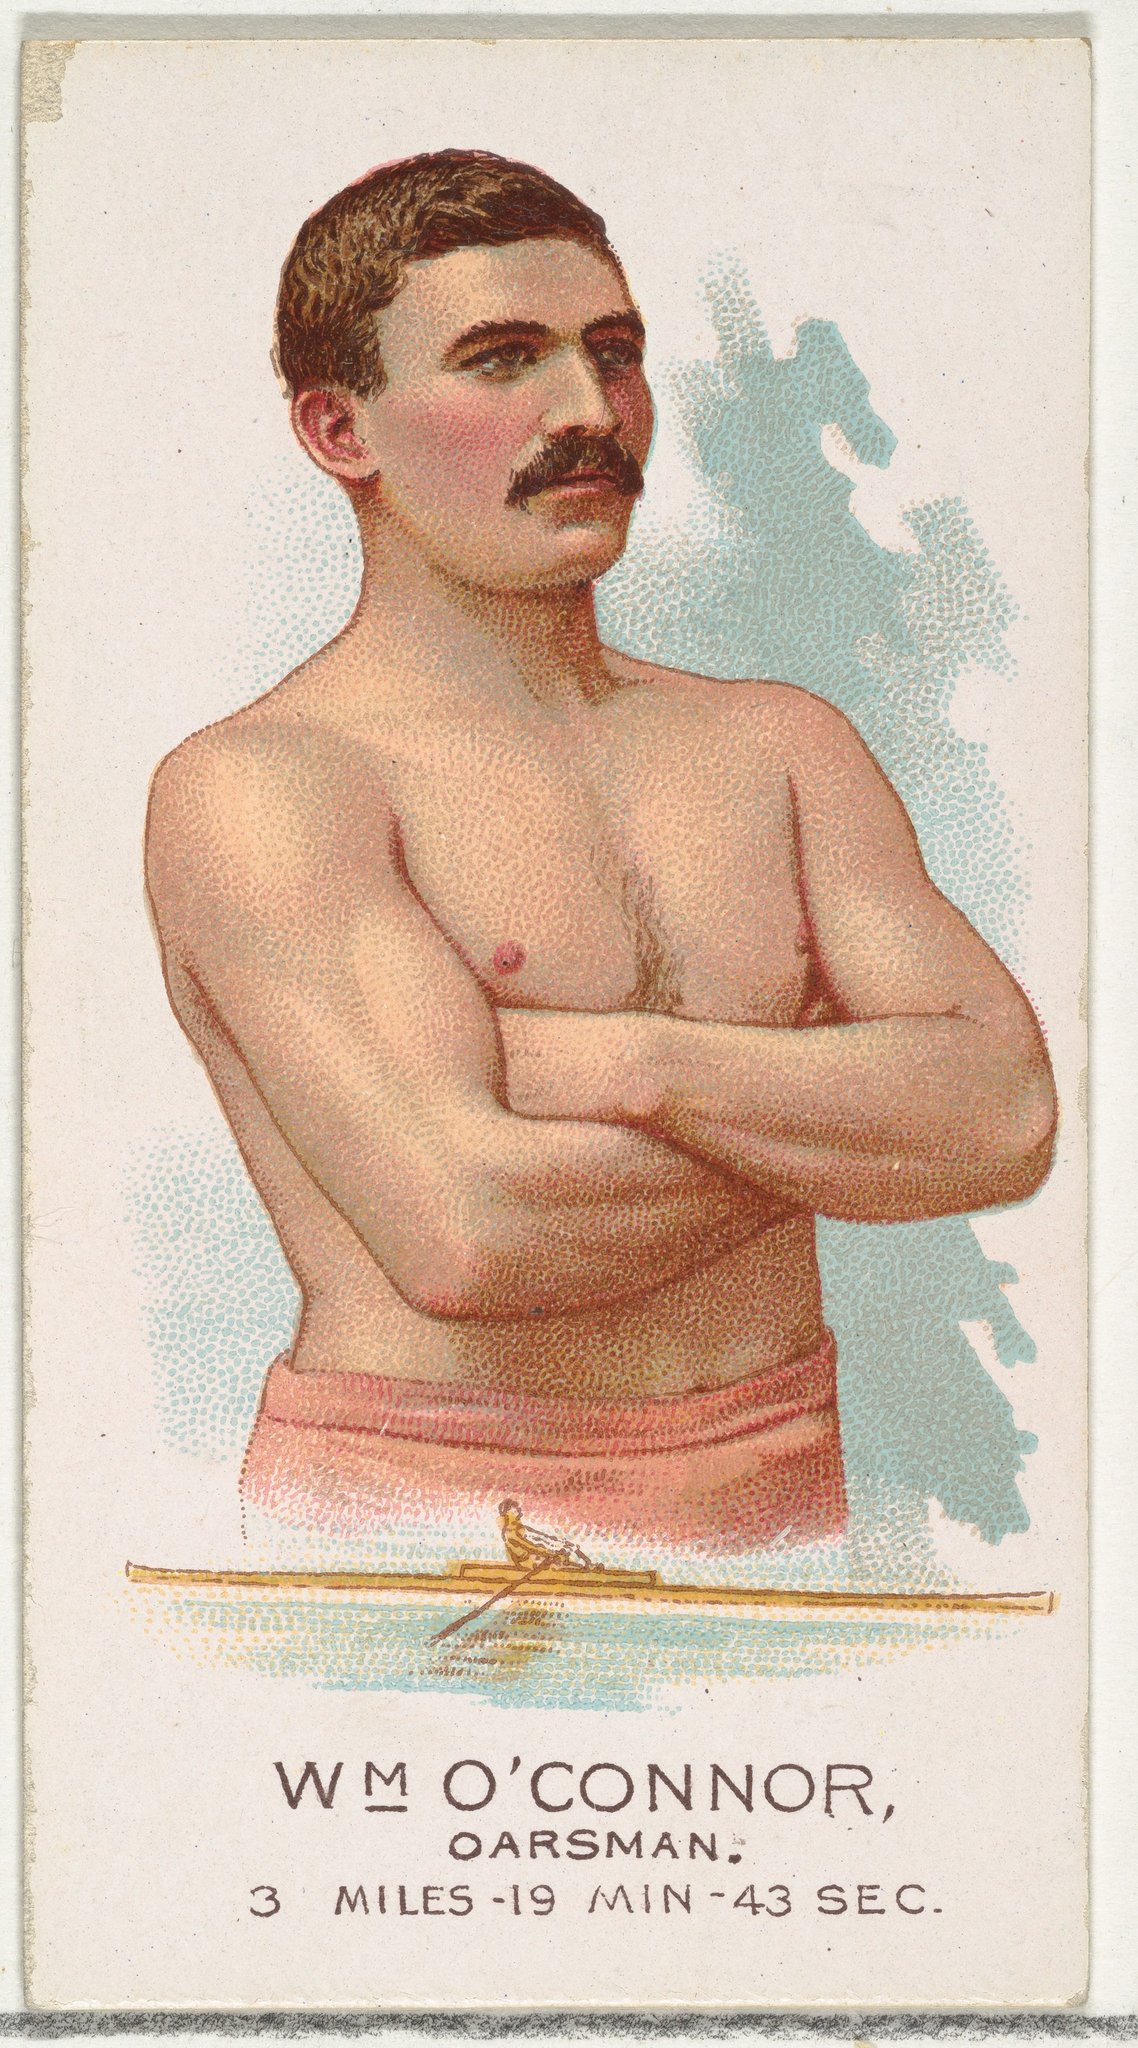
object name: print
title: William O'Connor, Oarsman, from World's Champions, Series 2 (N29) for Allen & Ginter Cigarettes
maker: allen & ginter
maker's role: publisher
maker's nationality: american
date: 1888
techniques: color lithograph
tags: men,portraits,athletes